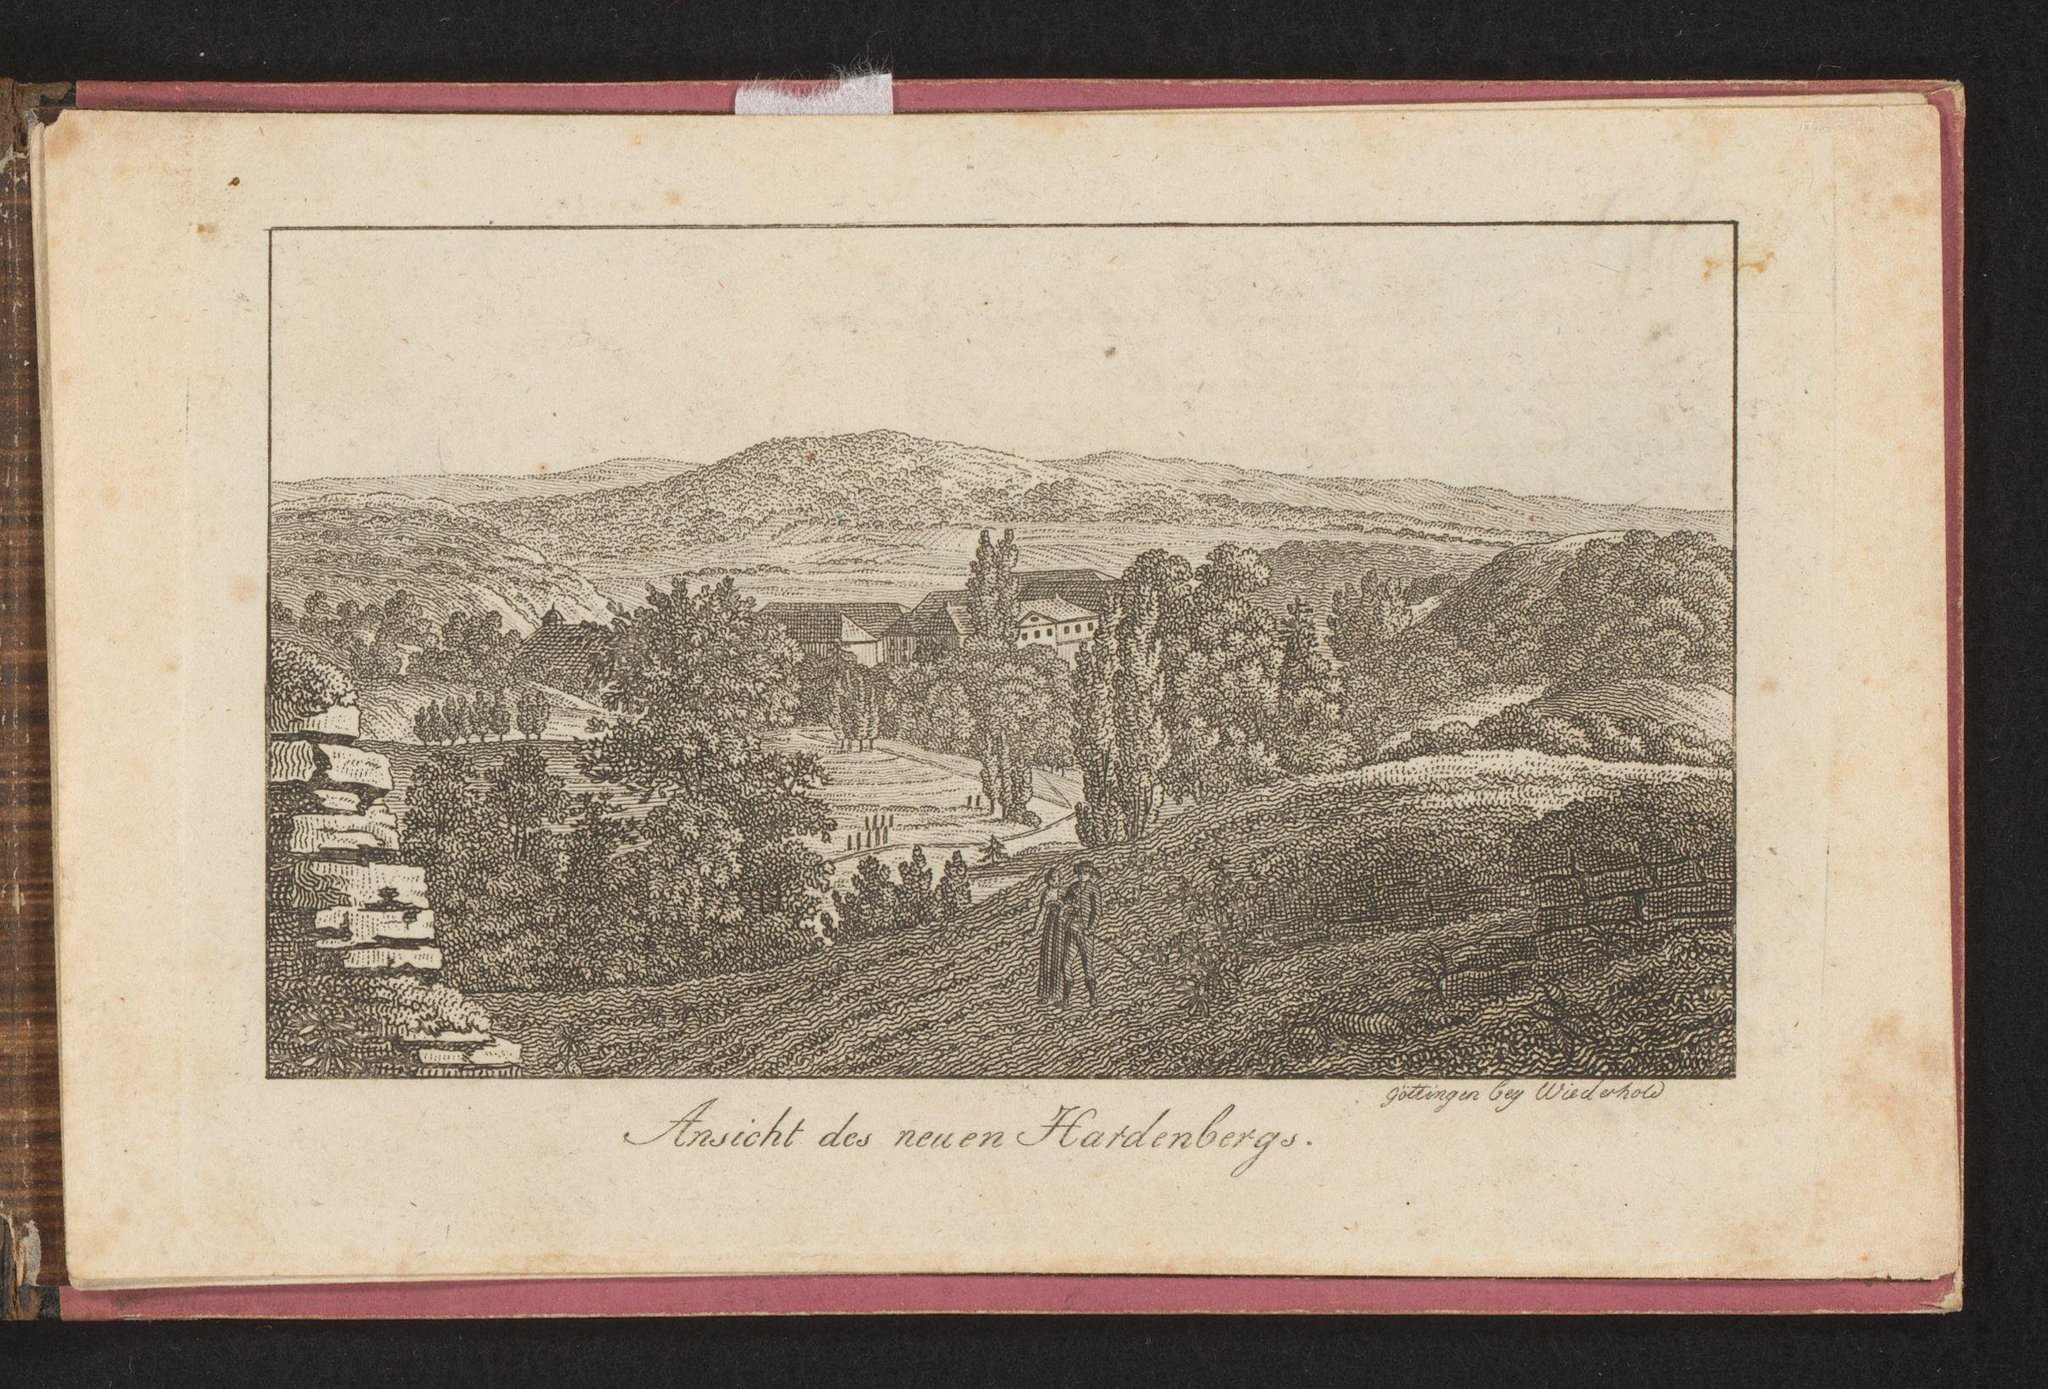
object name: print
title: Gezicht op Nörten-Hardenberg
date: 1770-1826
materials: ink, paper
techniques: etching, writing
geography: gottingen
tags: 'album amicorum', 'stammbuch', landscapes (+ landscape with figures, staffage)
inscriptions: tekst, verso, handgeschreven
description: Handgeschreven tekst in het Duits op het verso.